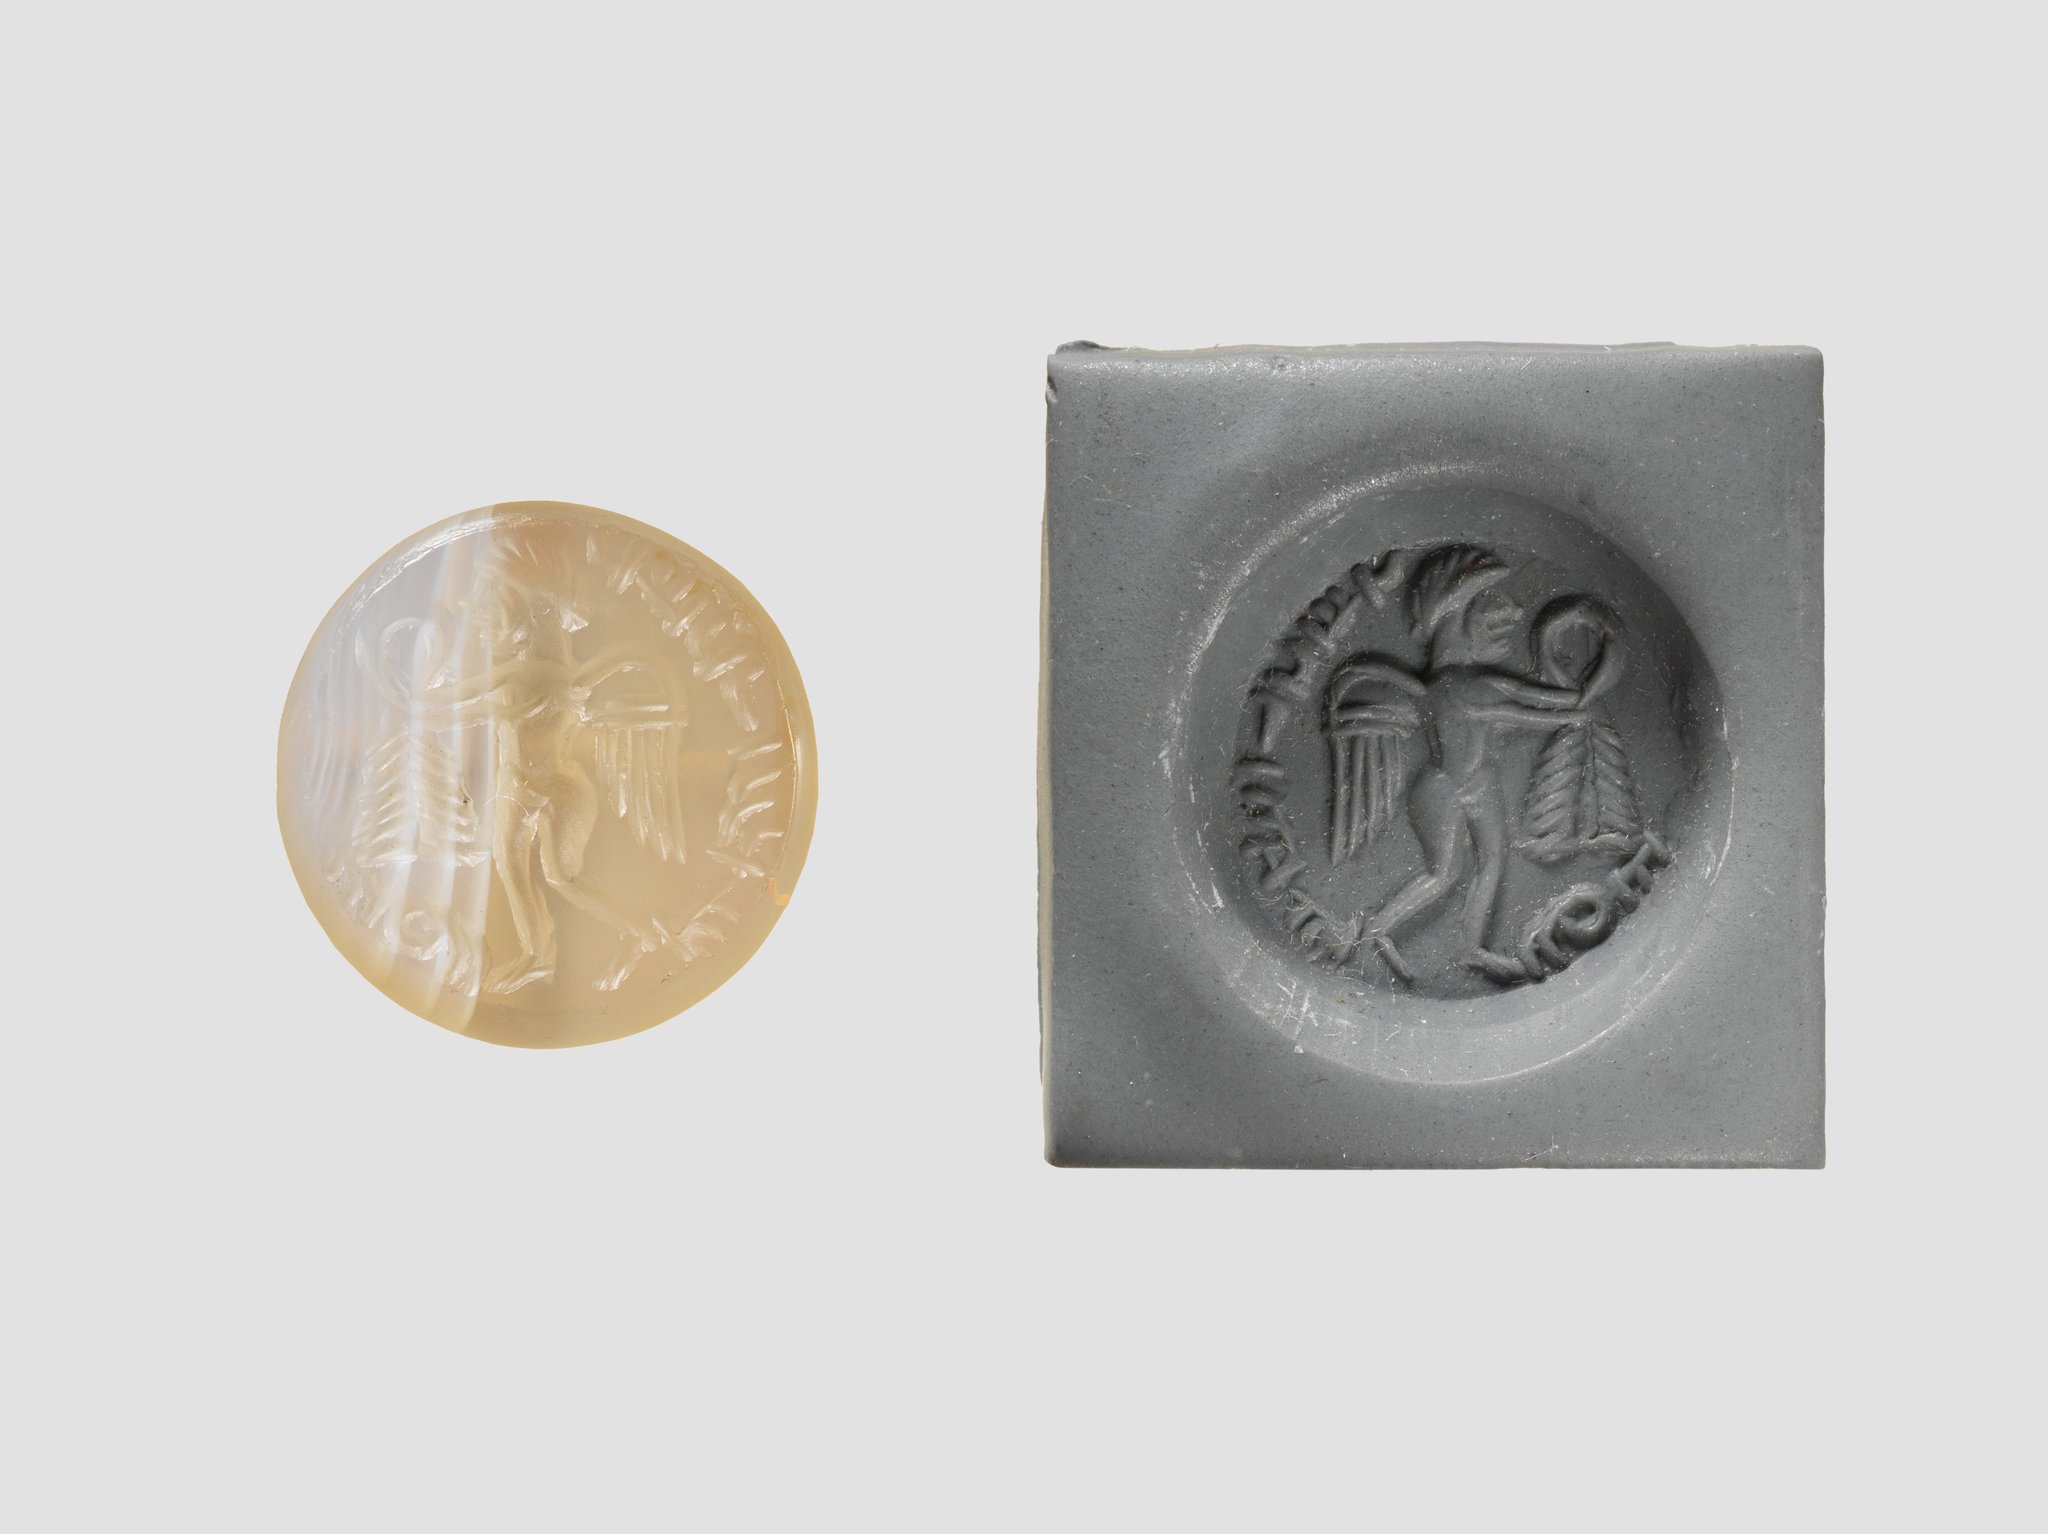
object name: stamp seal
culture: sasanian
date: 401-600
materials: stone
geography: iran or mesopotamia